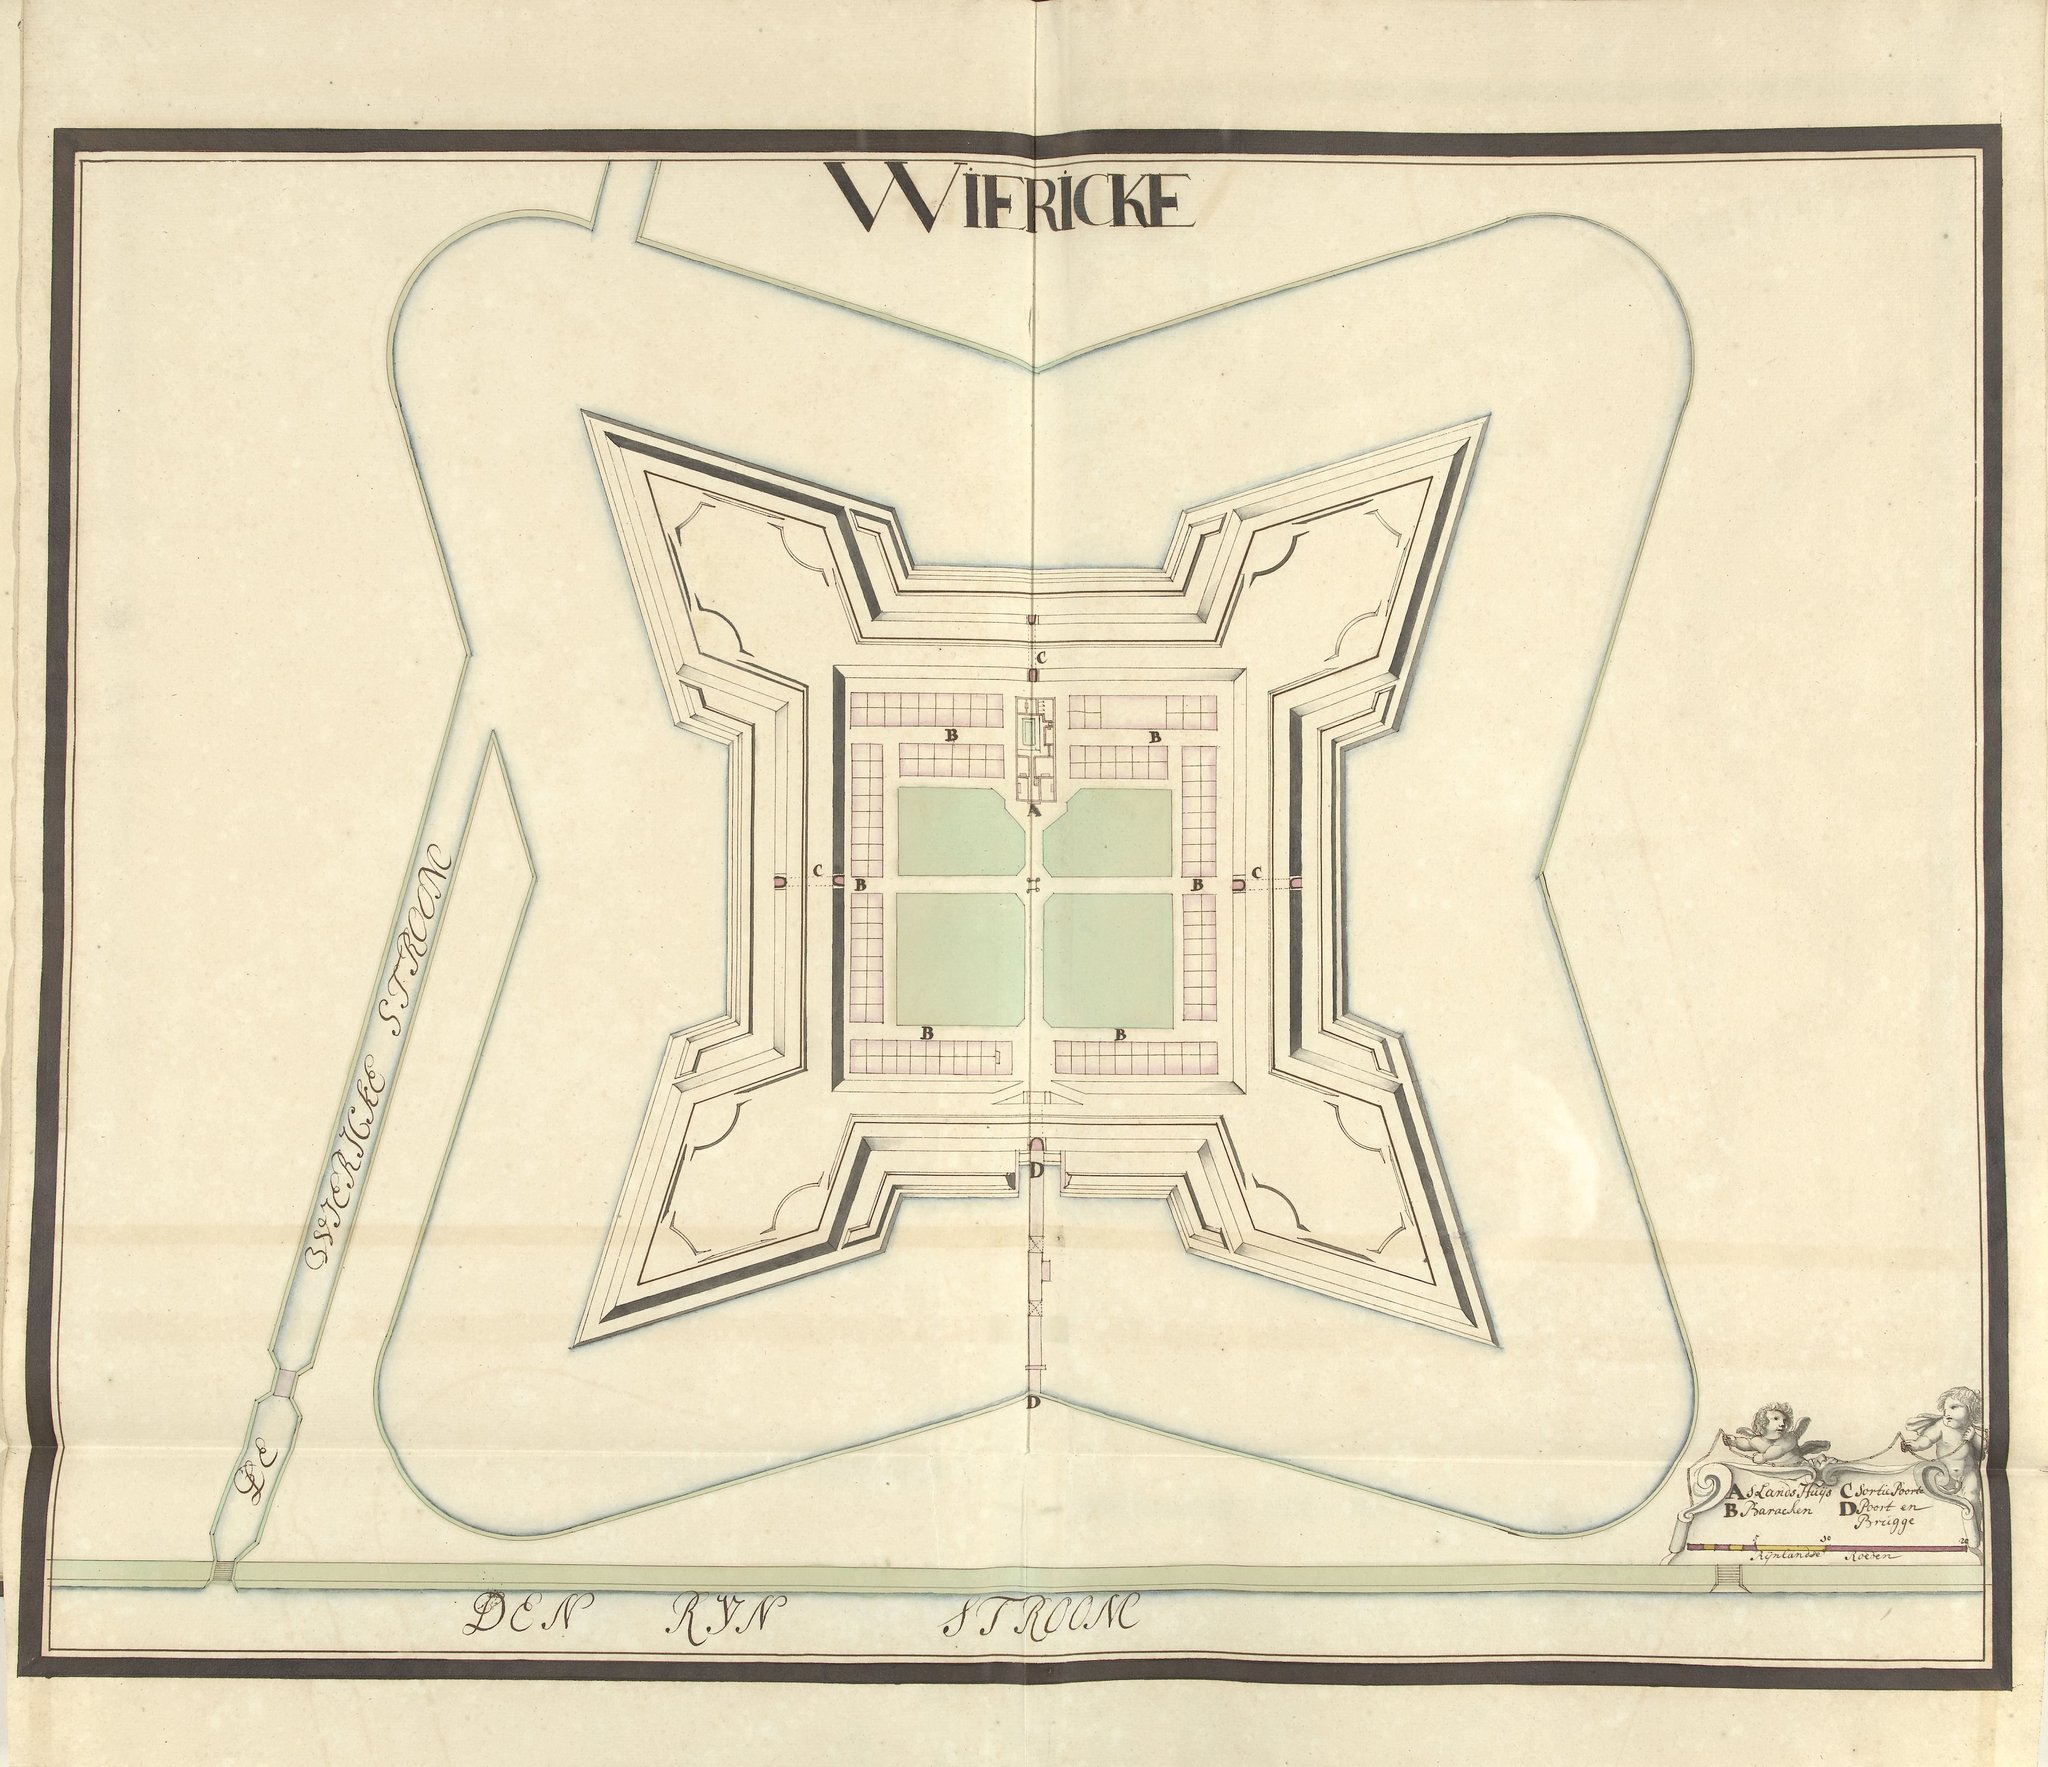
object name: drawing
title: Wiericke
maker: samuel du ry de champdoré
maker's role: draughtsman, engineer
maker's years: 1651-1729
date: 1701-1713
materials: paper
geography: netherlands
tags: fortress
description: Plattegrond van het Fort Wierickerschans (Wiericker Schans) te Bodegraven, ca. 1701-1715. Rechtsonder een cartouche met de legenda A-D in het Nederlands, met twee putti met een meetlint. Onderdeel van een verzameling getekende plannen van versterkte plaatsen in Nederland en omringende landen ten tijde van de Spaanse Successieoorlog (deel A).